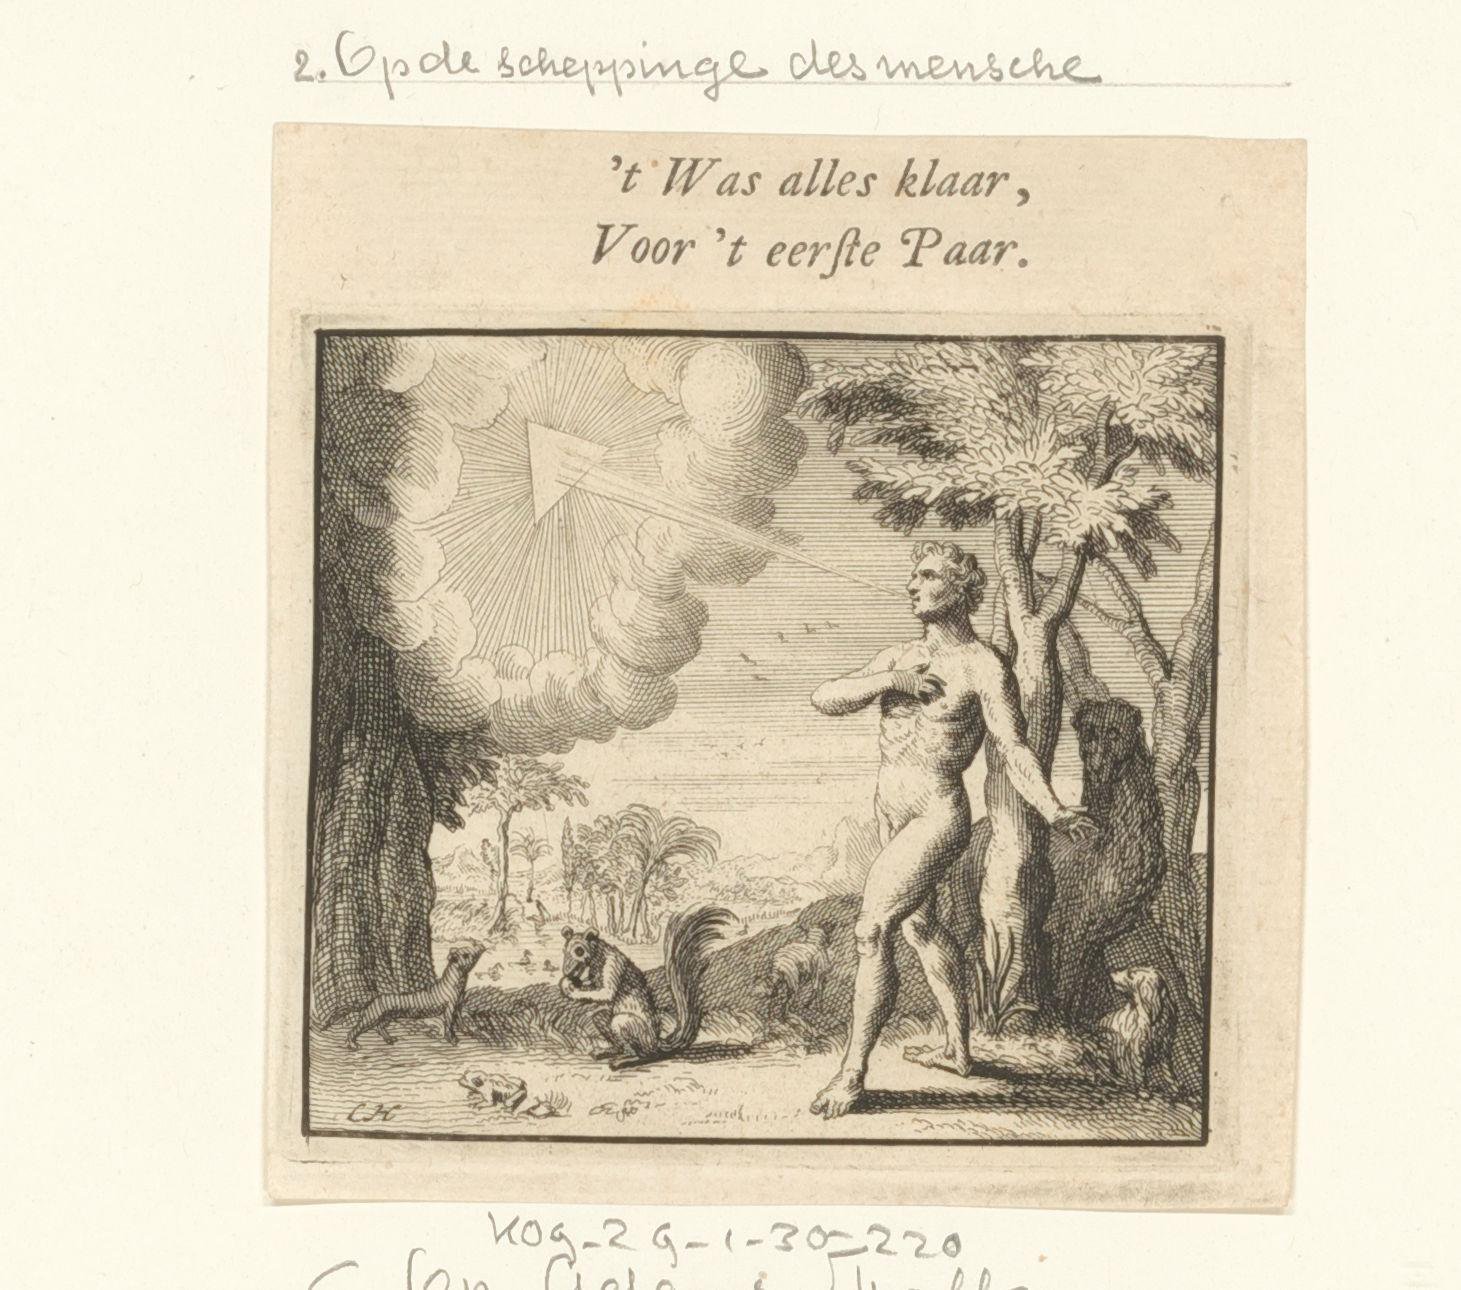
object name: print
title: 't Was alles klaar, Voor 't eerste Paar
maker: cornelis huyberts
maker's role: print maker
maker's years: 1669-1709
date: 1725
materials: paper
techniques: etching, letterpress printing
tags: creation of man; the garden of eden (genesis 1:26 - 2), adam in the garden of eden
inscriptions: collector's mark: Lugt 1641, stamp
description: Prent uit: Graauwhart, Hendrik. Voorbeeldelyke zeede-lessen, genoomen uyt den eersten toestand des werelds (...). Amsterdam: Johannes Ratelband, 1725. Prent ook gebruikt voor eerdere en (1709) latere uitgave (1756, 1761 en 1764).